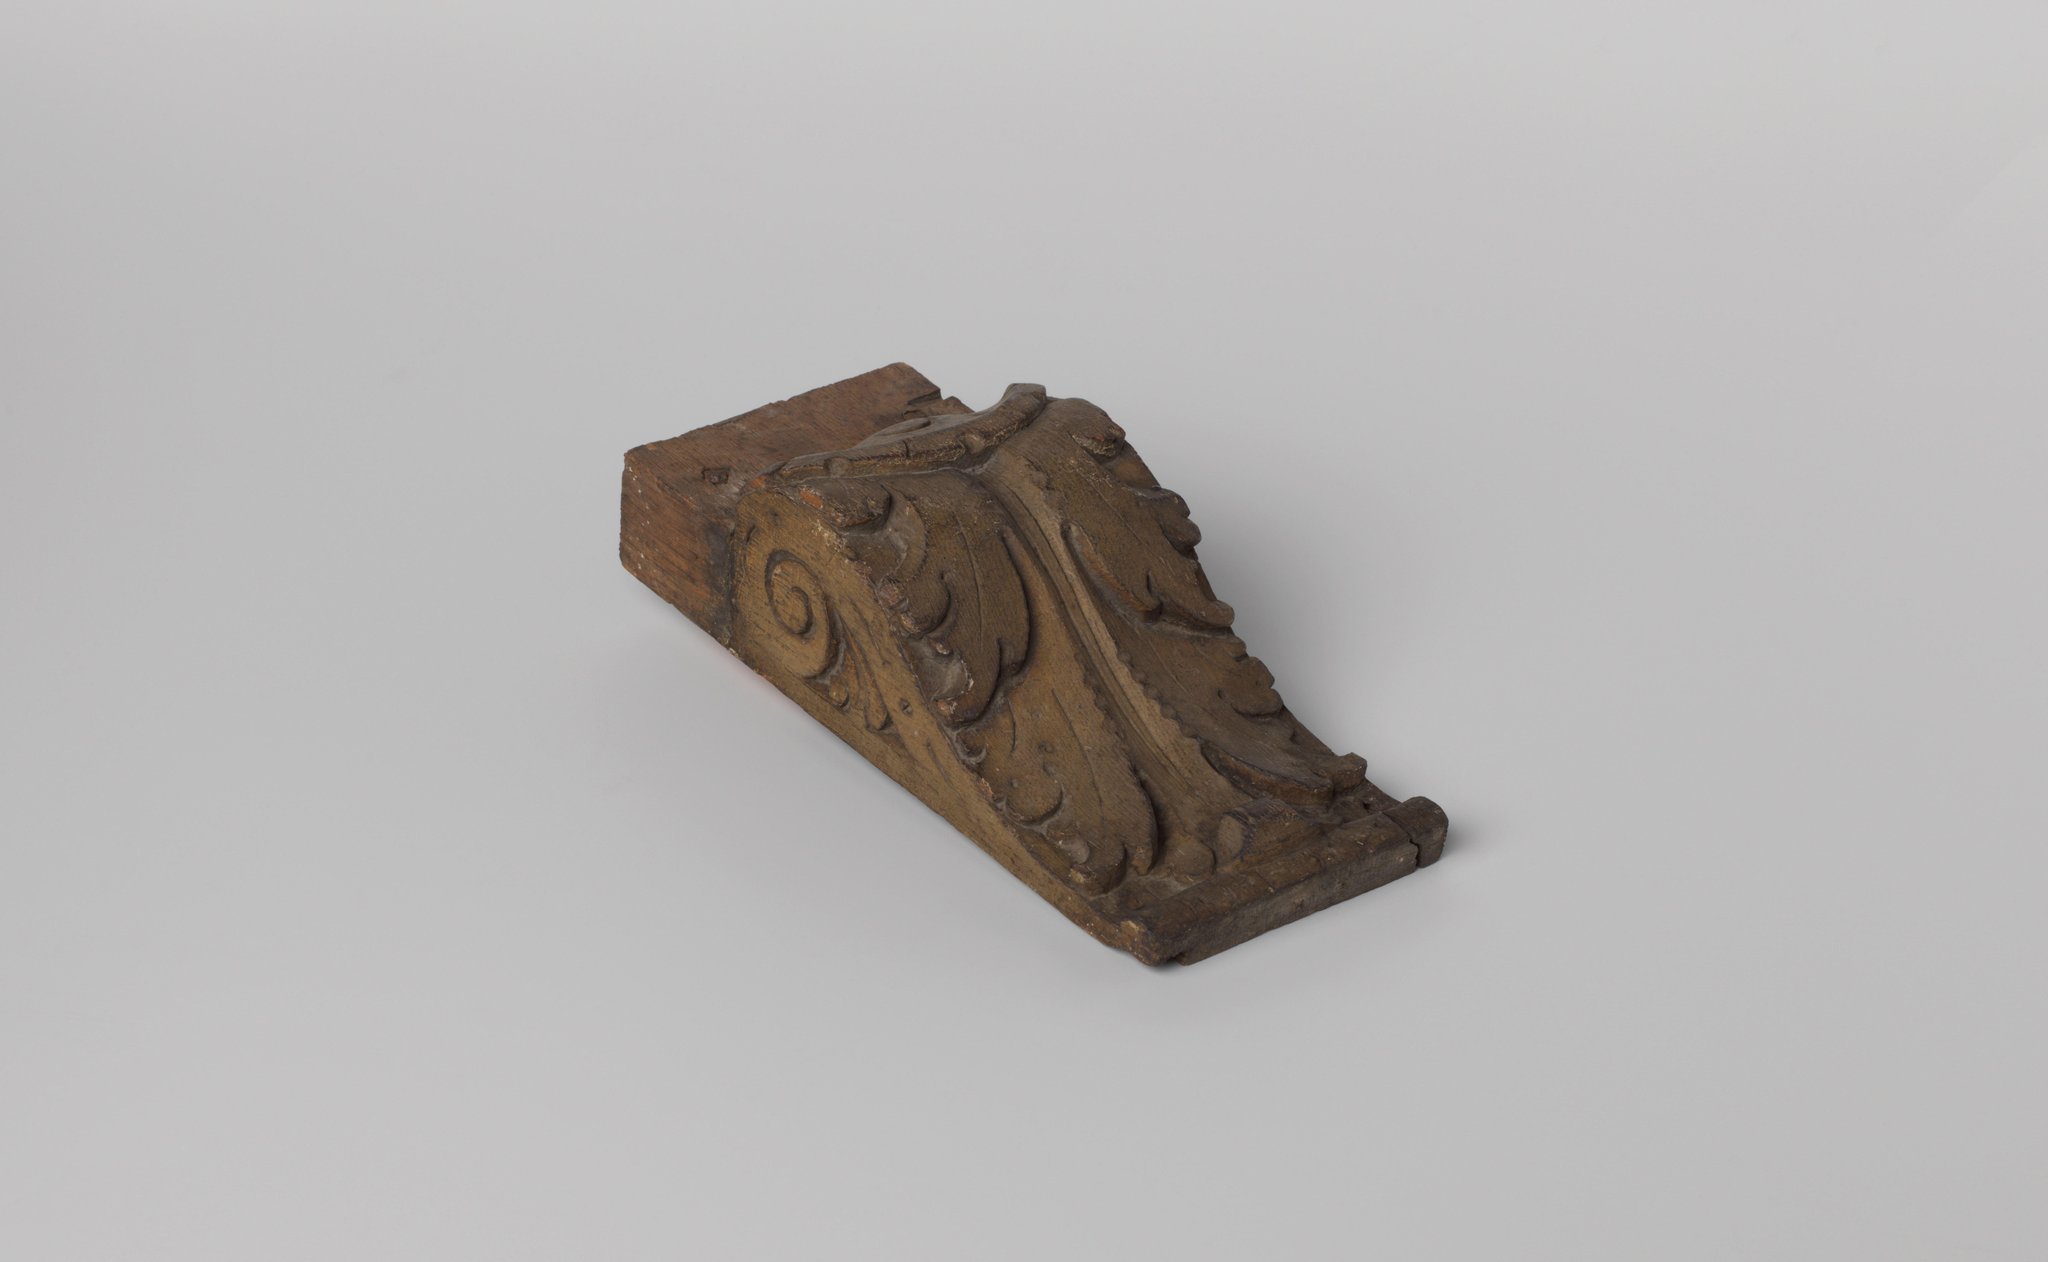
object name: console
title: Console met gesneden ornament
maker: Anonymous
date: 1400-1950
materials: wood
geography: netherlands